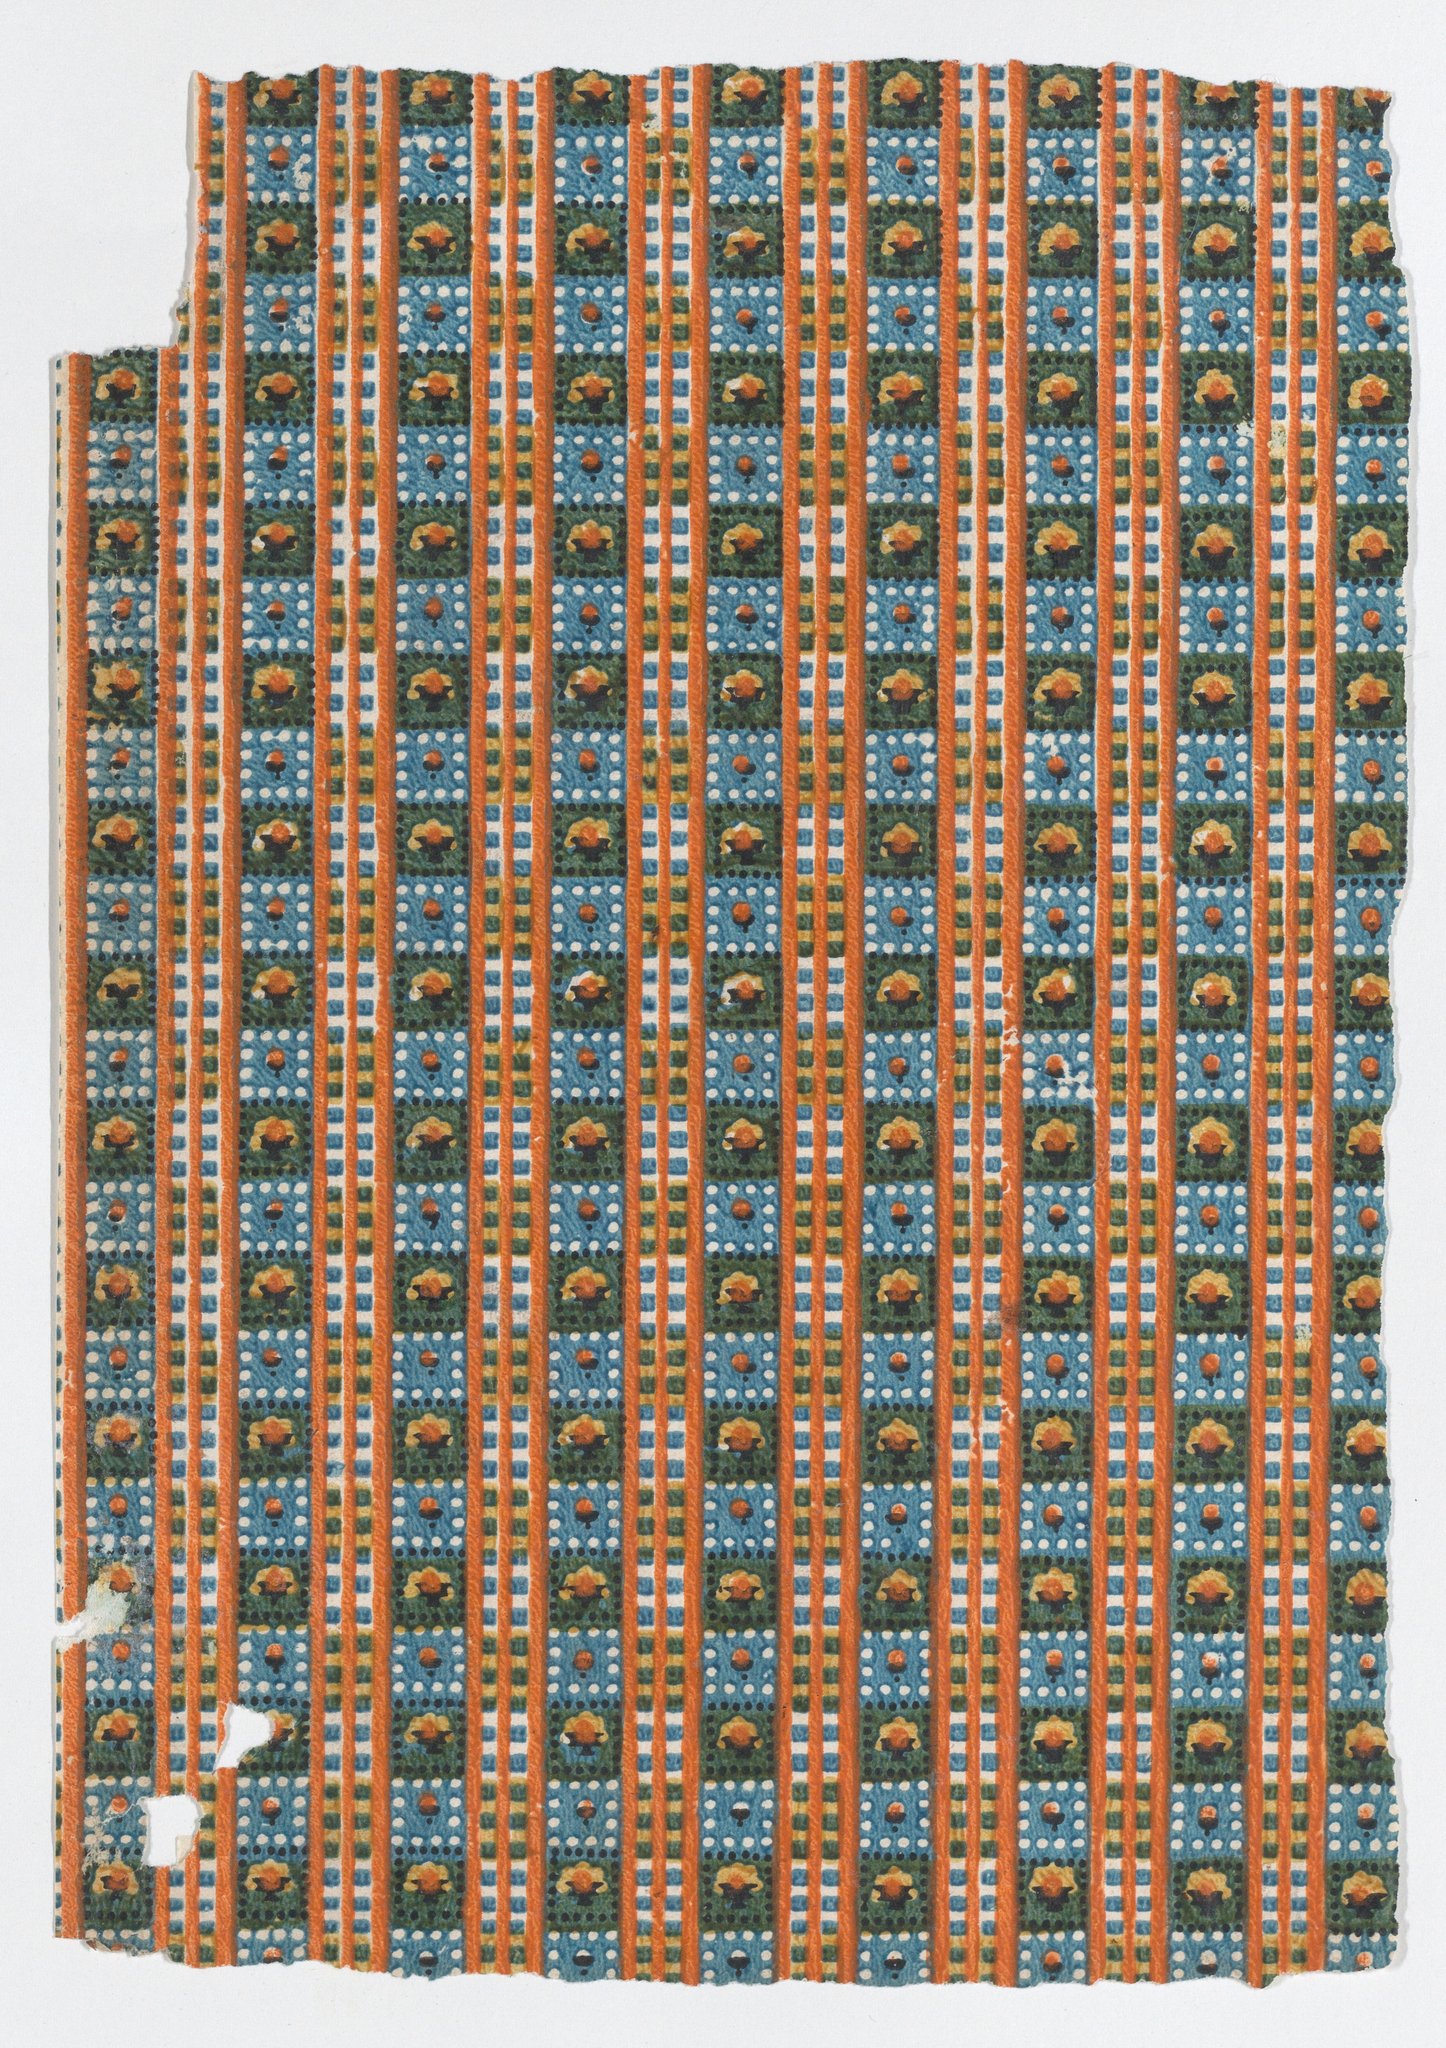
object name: print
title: Sheet with an overall geometric pattern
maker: Anonymous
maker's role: artist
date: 1767-1866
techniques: relief print